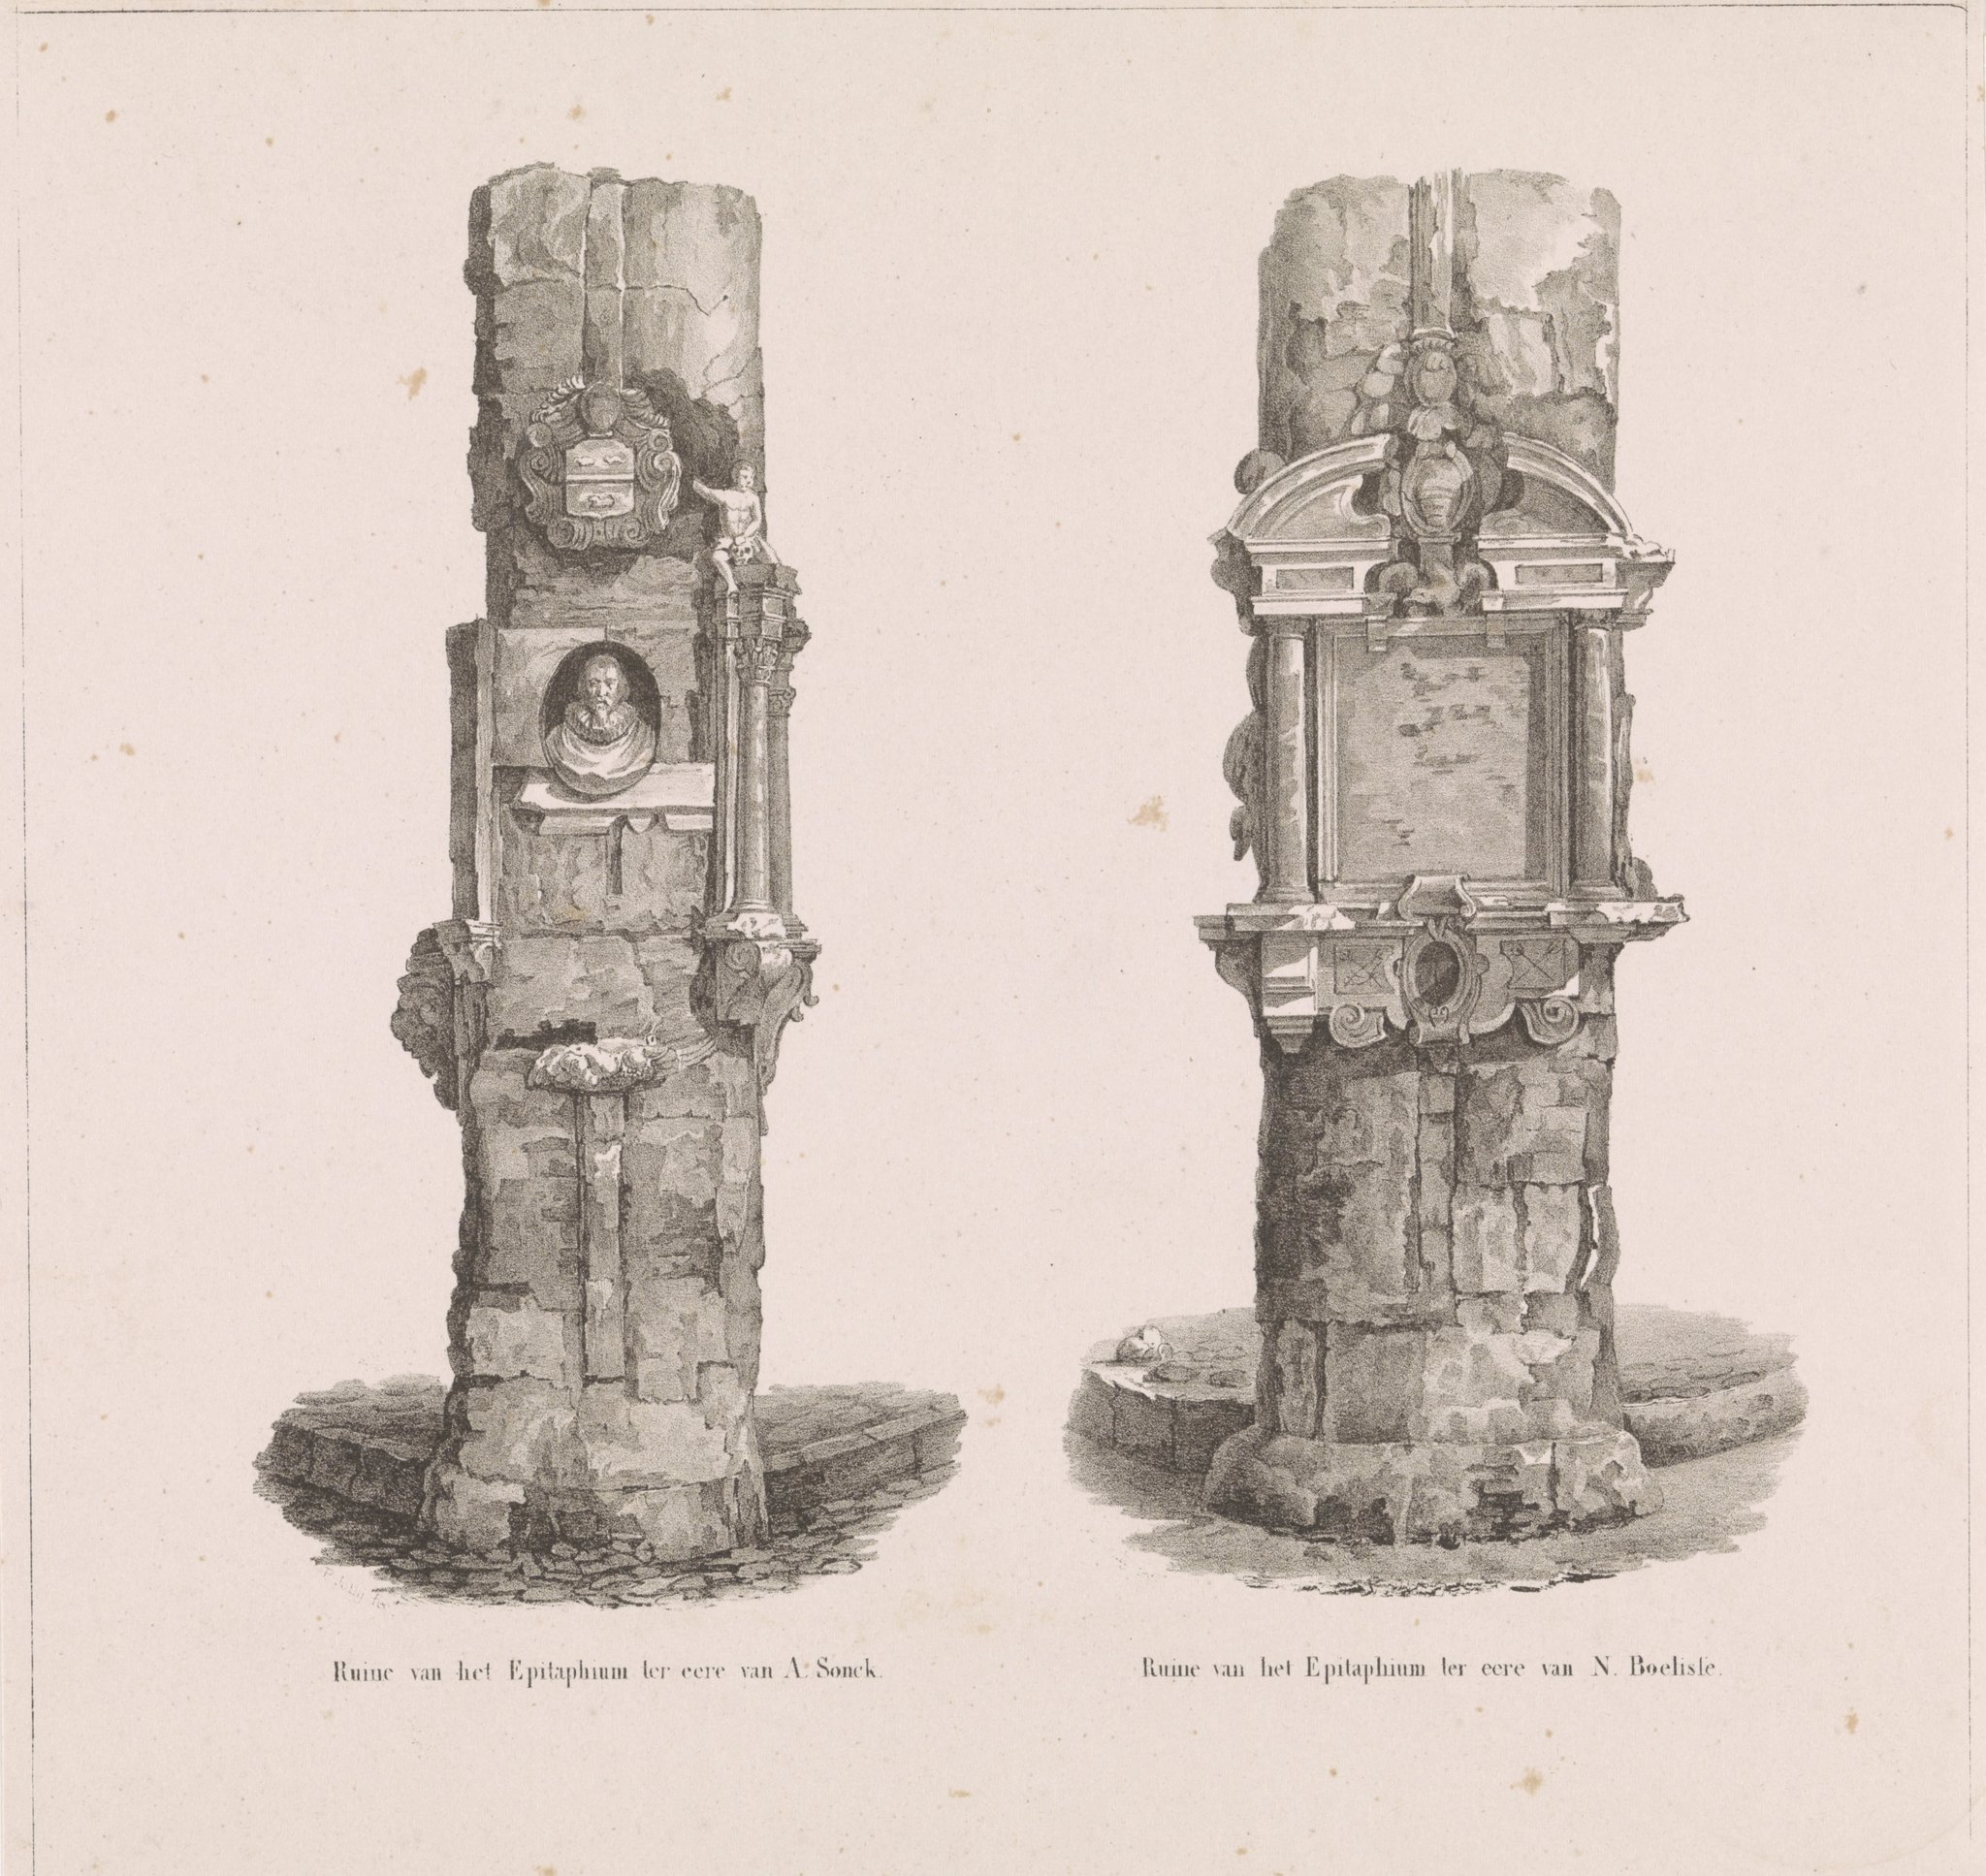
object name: print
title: Ruine van het Epitaphium ter eere van (...)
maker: paulus jolly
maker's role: draughtsman, print maker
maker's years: 1805-1856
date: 1830-1856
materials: paper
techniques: lithograph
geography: north holland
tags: epitaph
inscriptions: collector's mark: Lugt 2228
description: Epitaaf ter ere van A. Sonck, met diens portret, en een epitaaf ter ere van N. Boelisle.